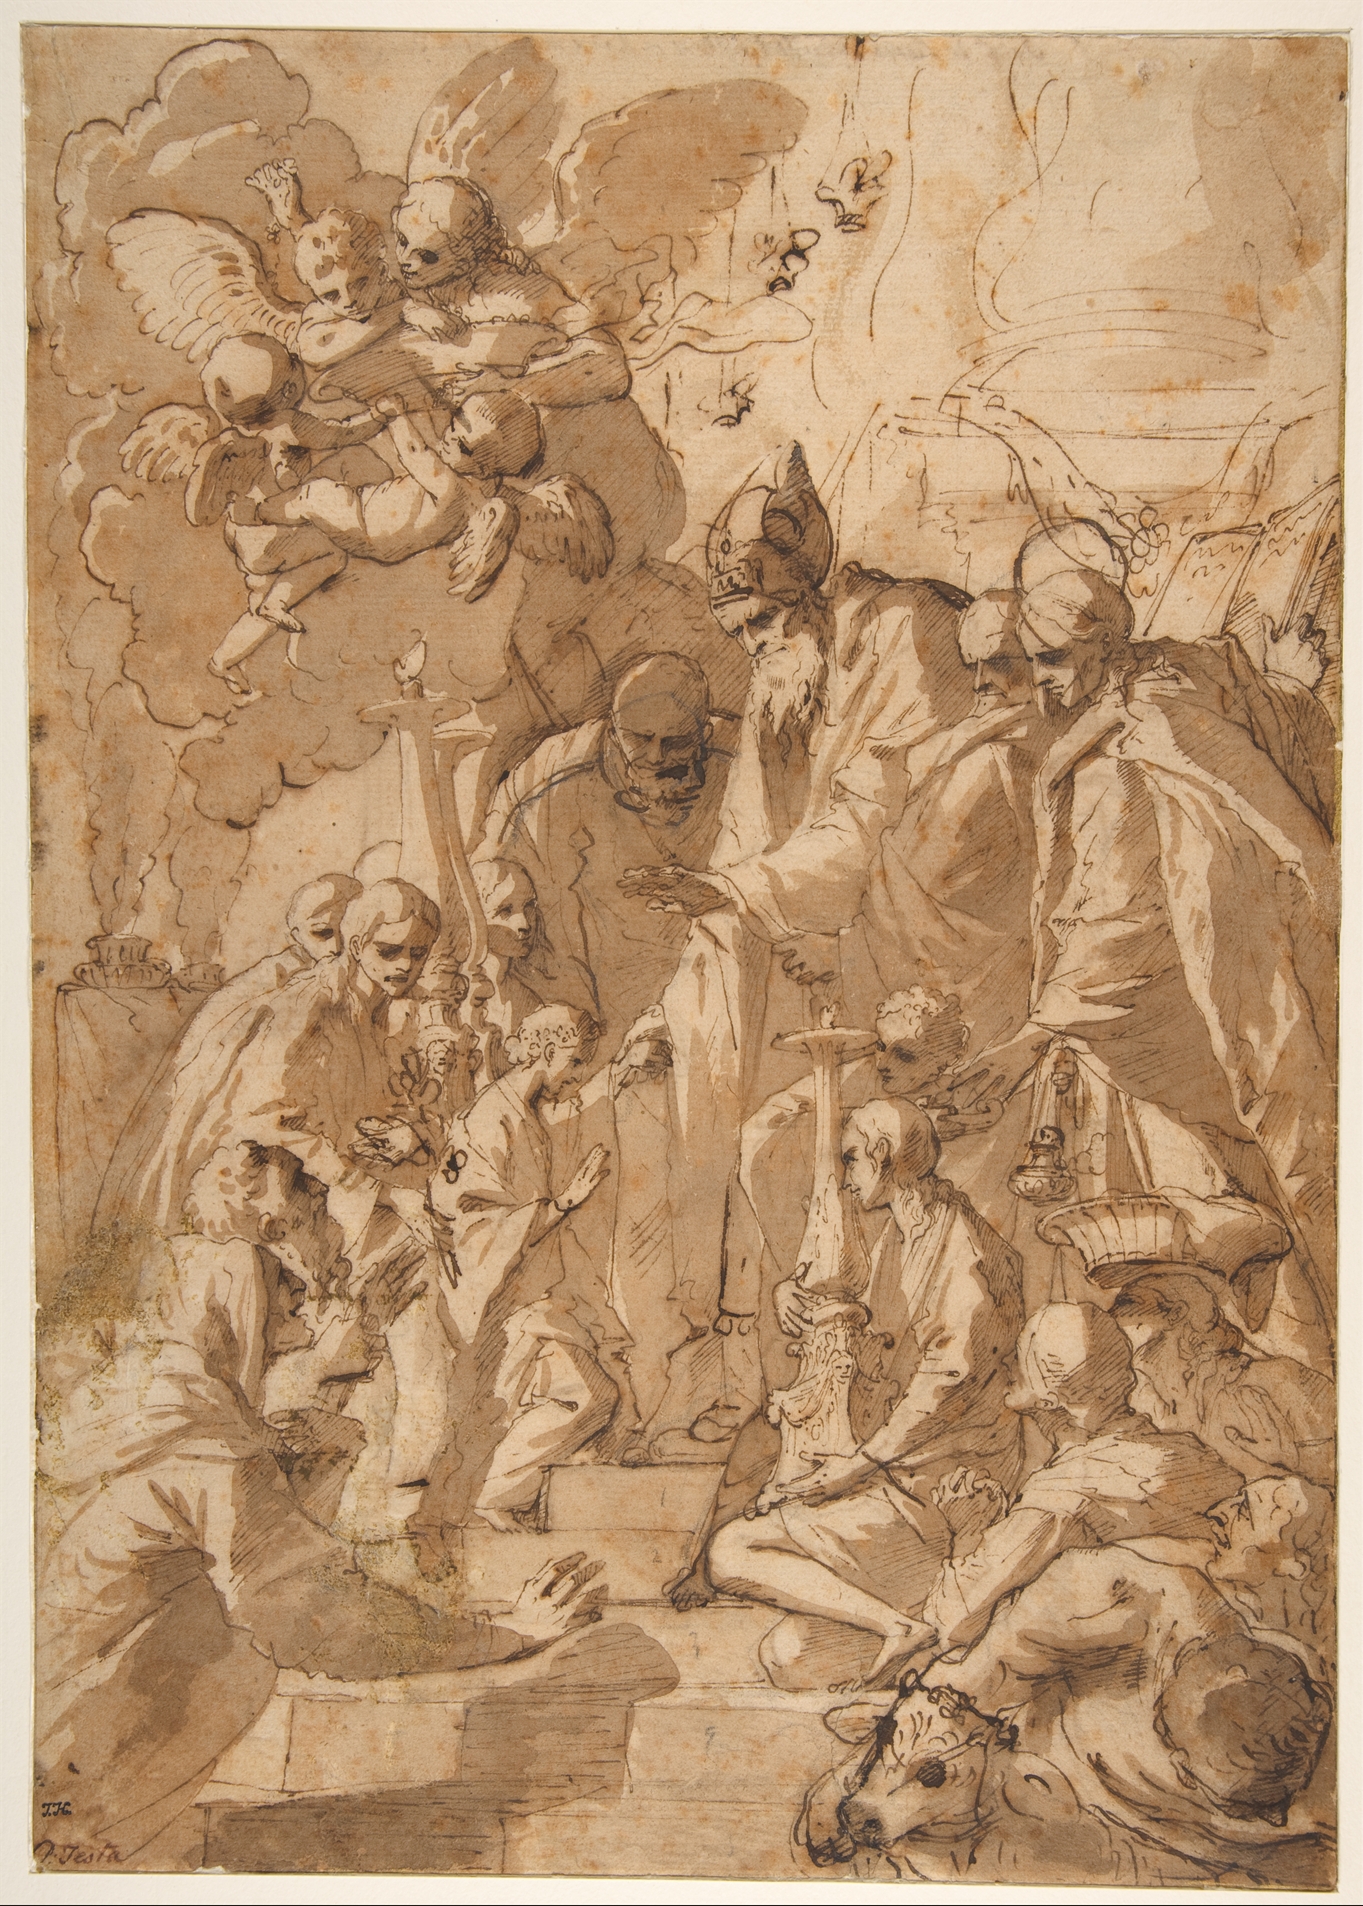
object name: drawing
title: The Presentation of the Virgin in the Temple (recto); Another Design for the Same Composition (verso)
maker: pietro testa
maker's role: artist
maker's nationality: italian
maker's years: 1612-1650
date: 1612-1650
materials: ink, paper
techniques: brush, pen, wash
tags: men,angels,virgin mary